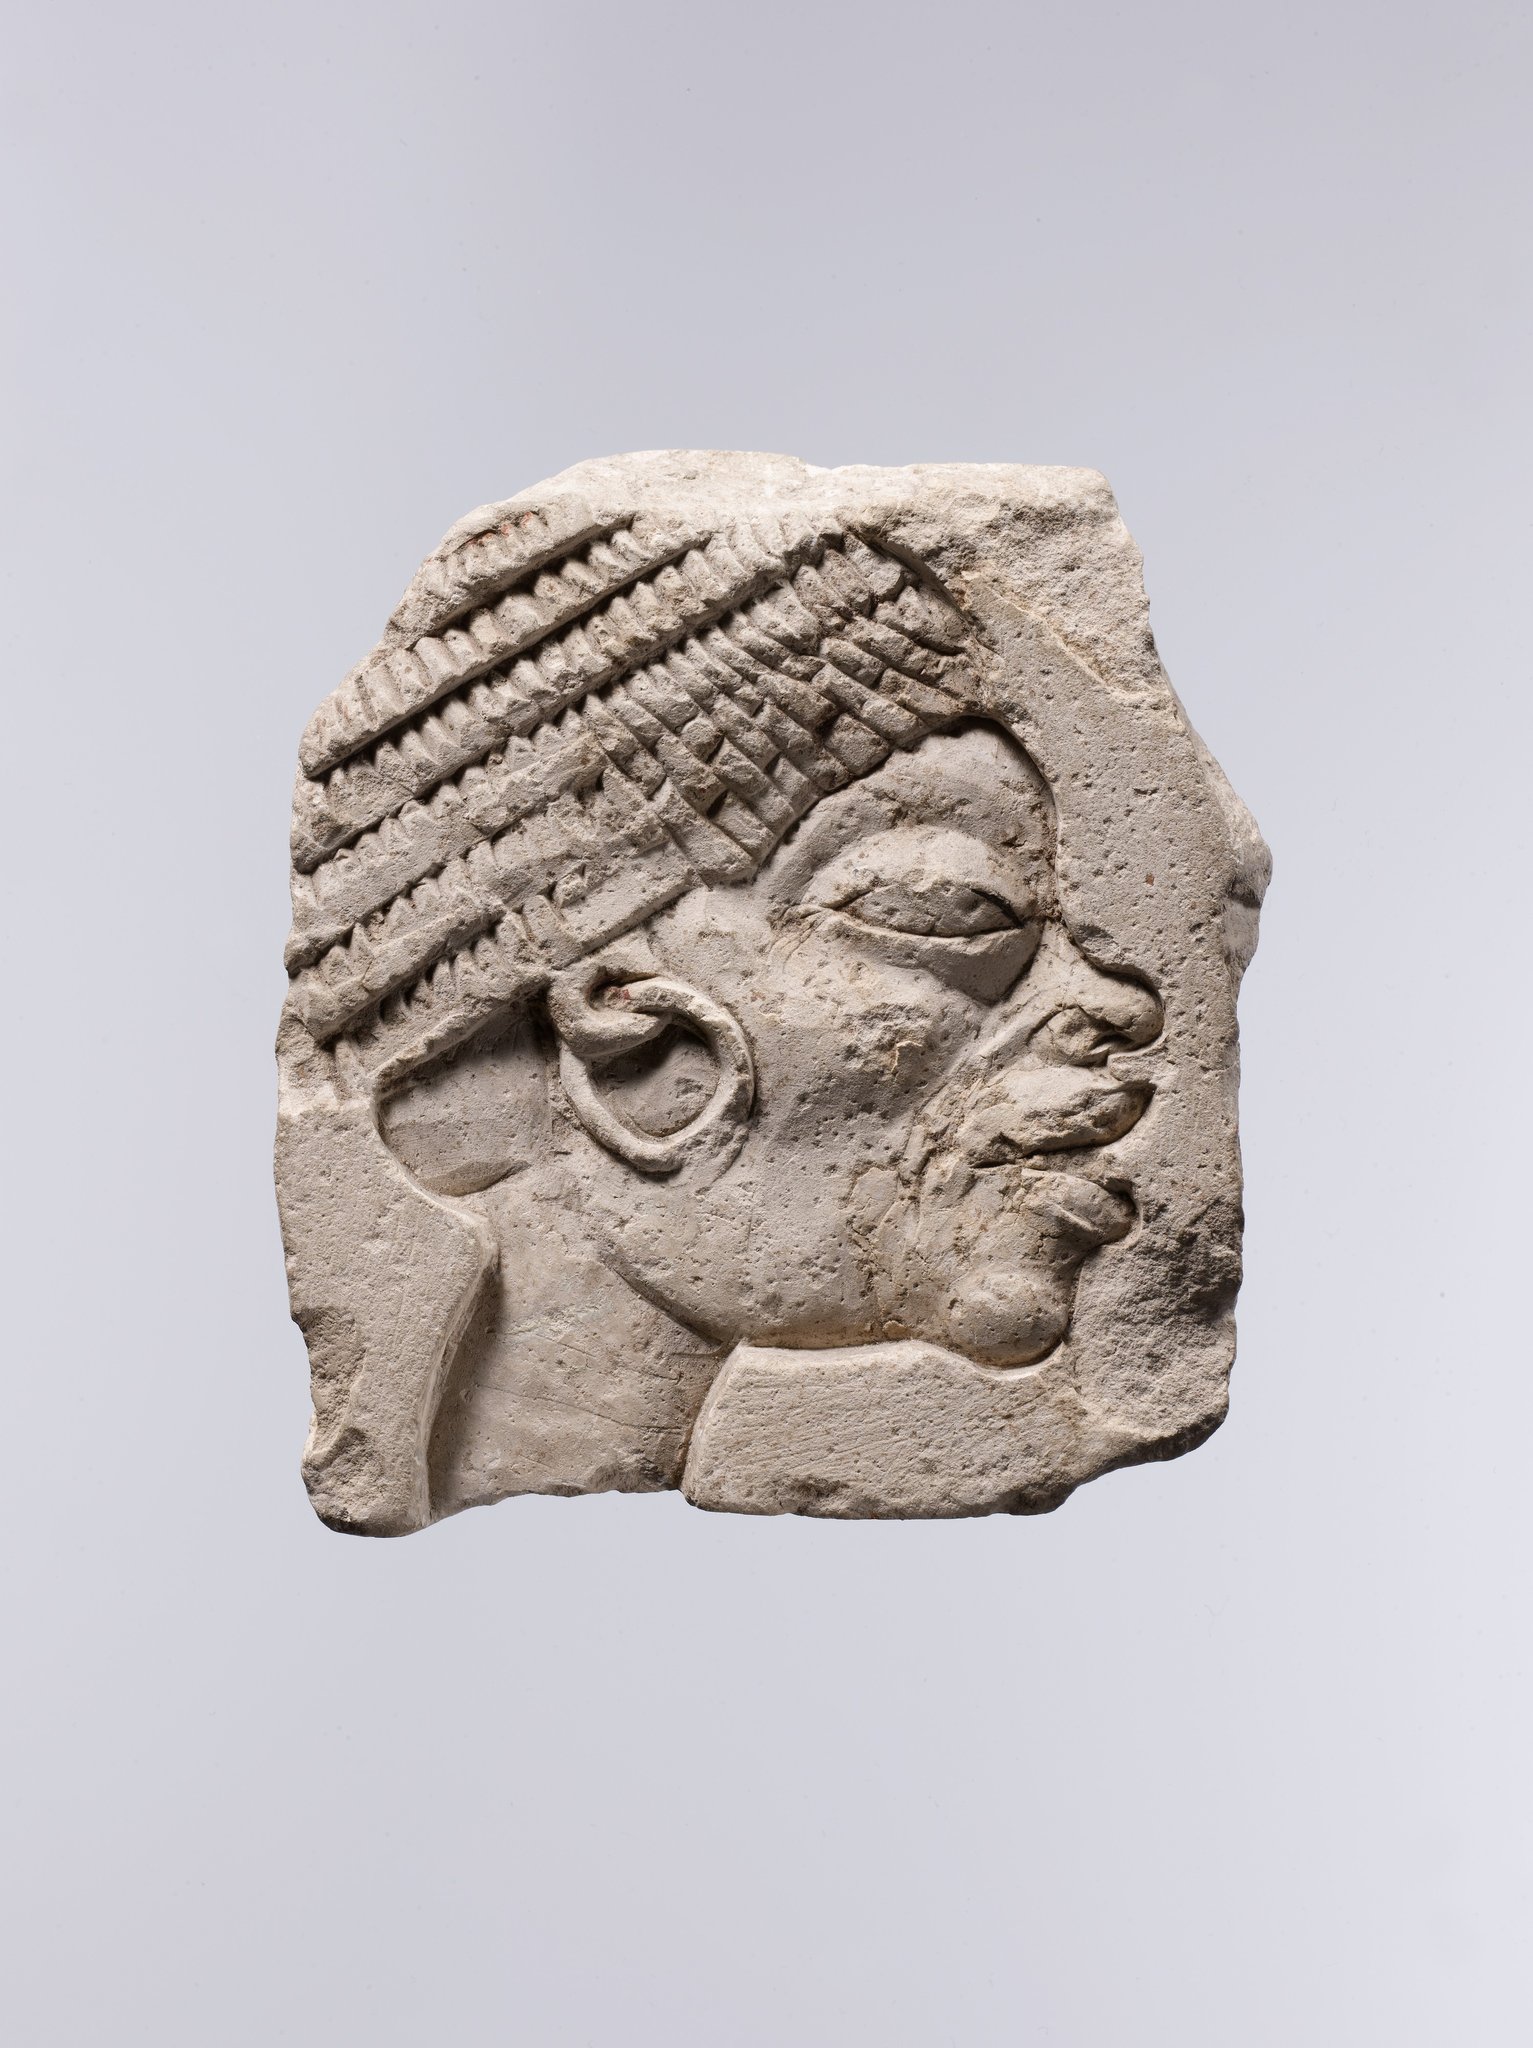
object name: trial piece, relief of a nubian head, earring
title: Head of a Nubian Man (Sculptor's Trial Piece?)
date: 1353-1336 BCE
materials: limestone, paint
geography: egypt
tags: heads